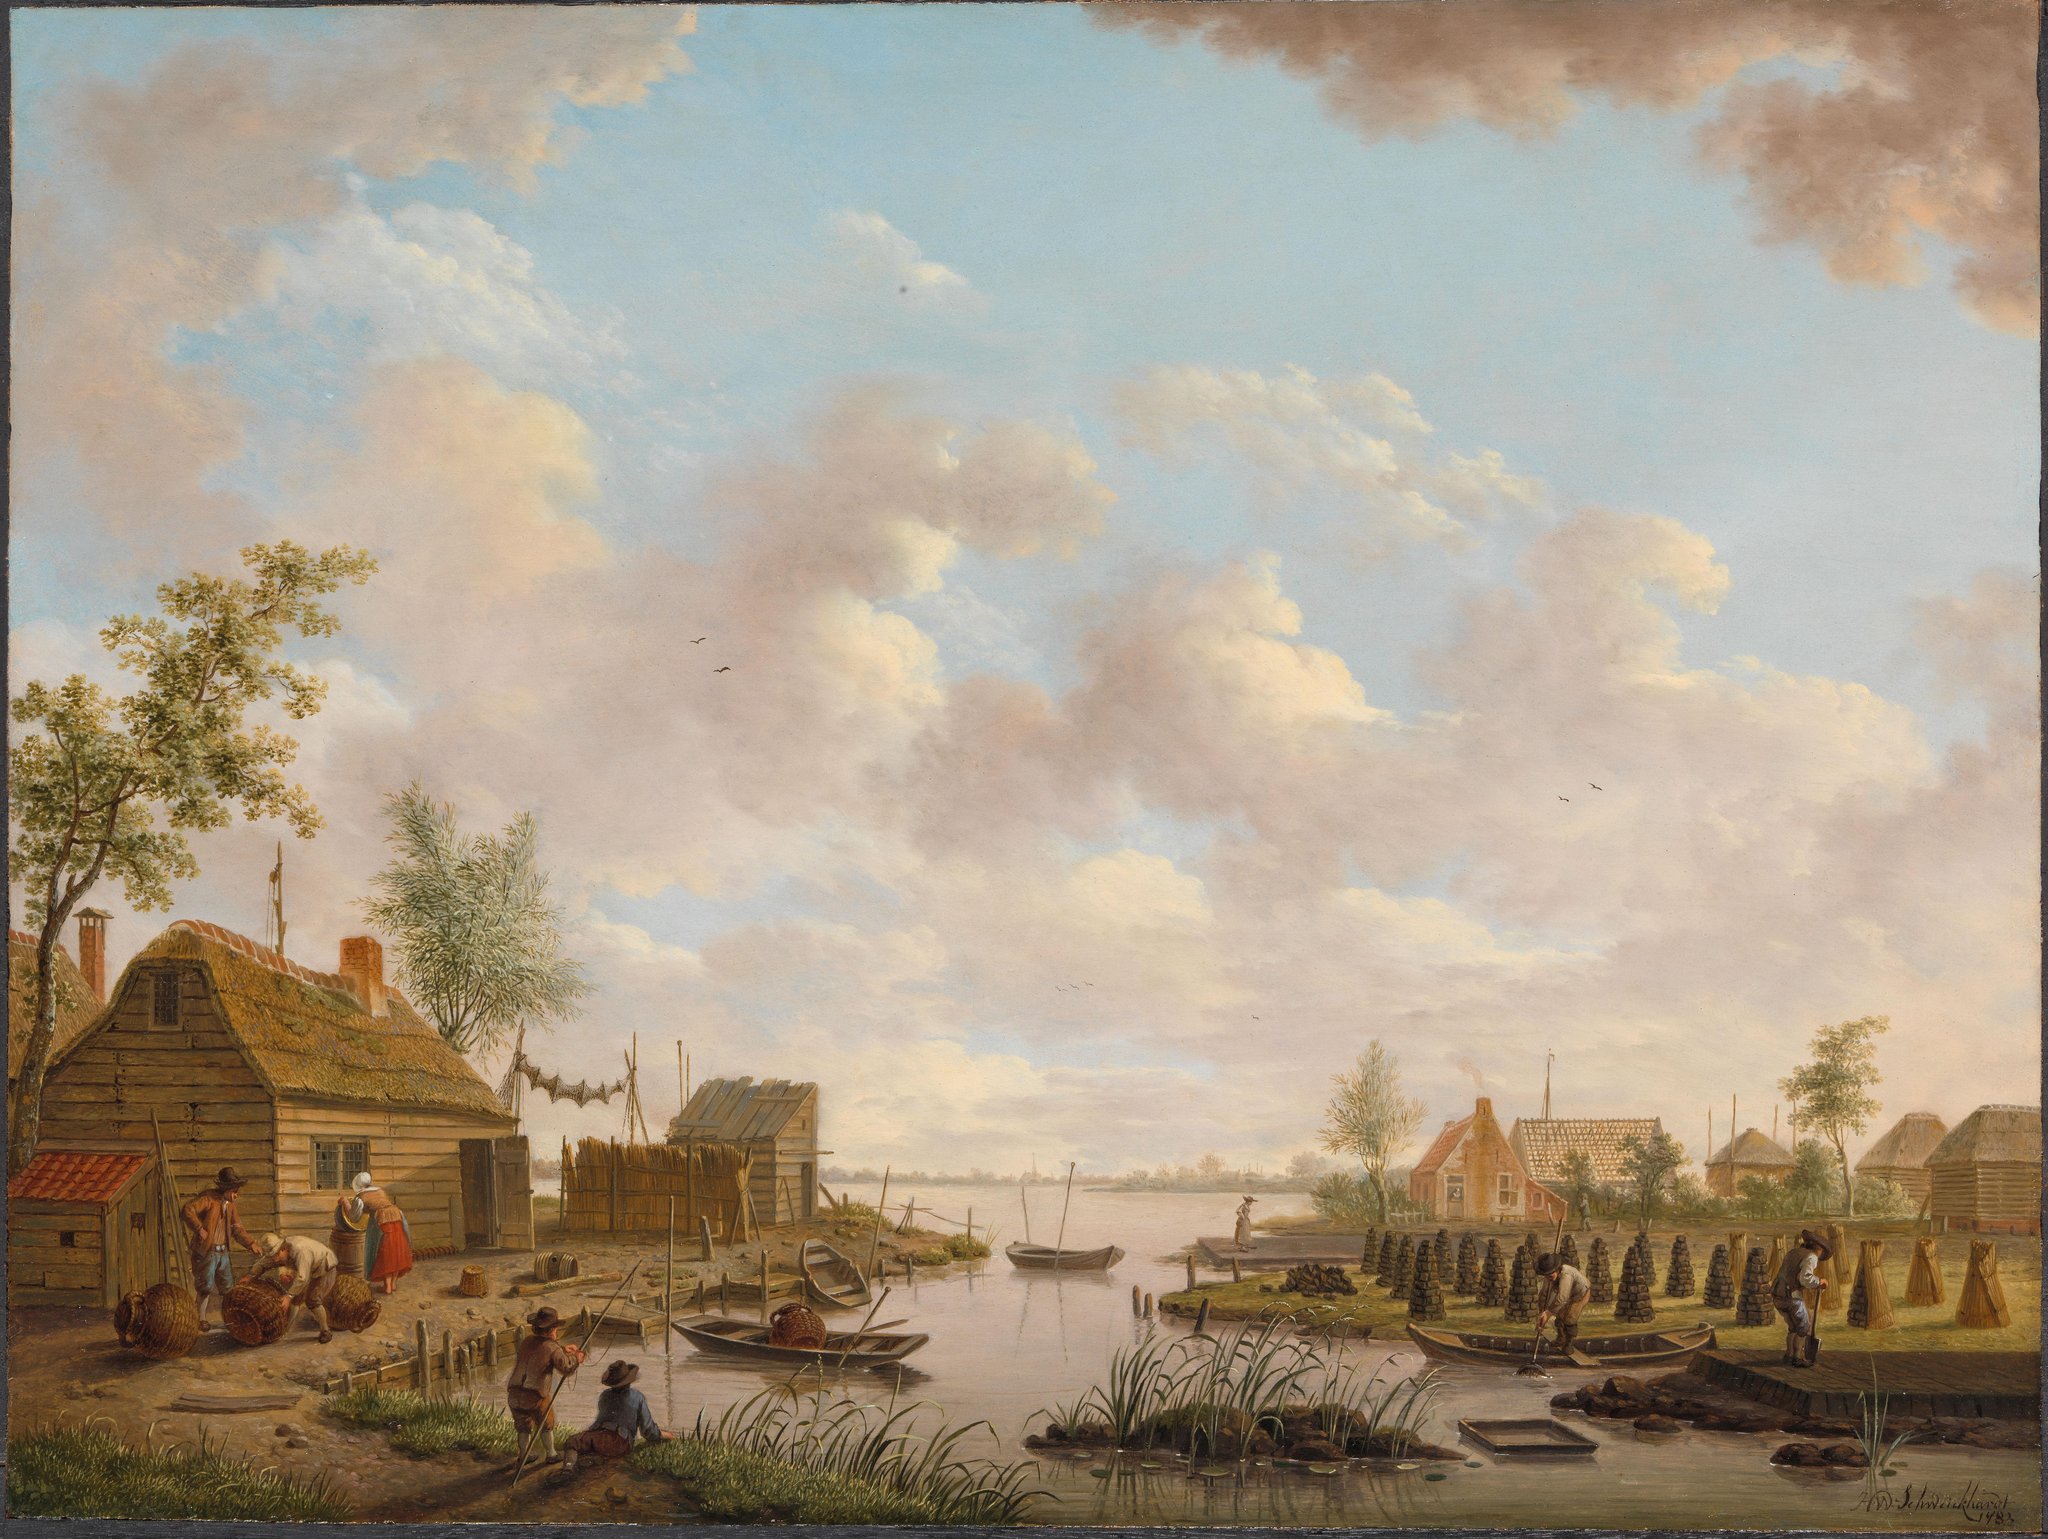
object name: painting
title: Landscape with Fishermen and Farmers Extracting Peat in a Marsh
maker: hendrik willem schweickhardt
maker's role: draughtsman, painter, print maker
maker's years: 1746-1797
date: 1783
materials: oil, panel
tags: peat (soil type), peat-cutting, landscapes in the temperate zone, angling, netherlands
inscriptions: signature and date: ‘H.W. Schweickhardt 1783’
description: Here, peat –an important source of fuel –is being extracted from below the water table, a common technique in the west and north of the Netherlands. The man in the little boat dredges the peat from the water; it is then spread out on the ground. The woman in the distance stamps the peat drying in the sun into a hard mass. This is subsequently cut with a spade into easy-to-use blocks, which are then left to dry out fully.